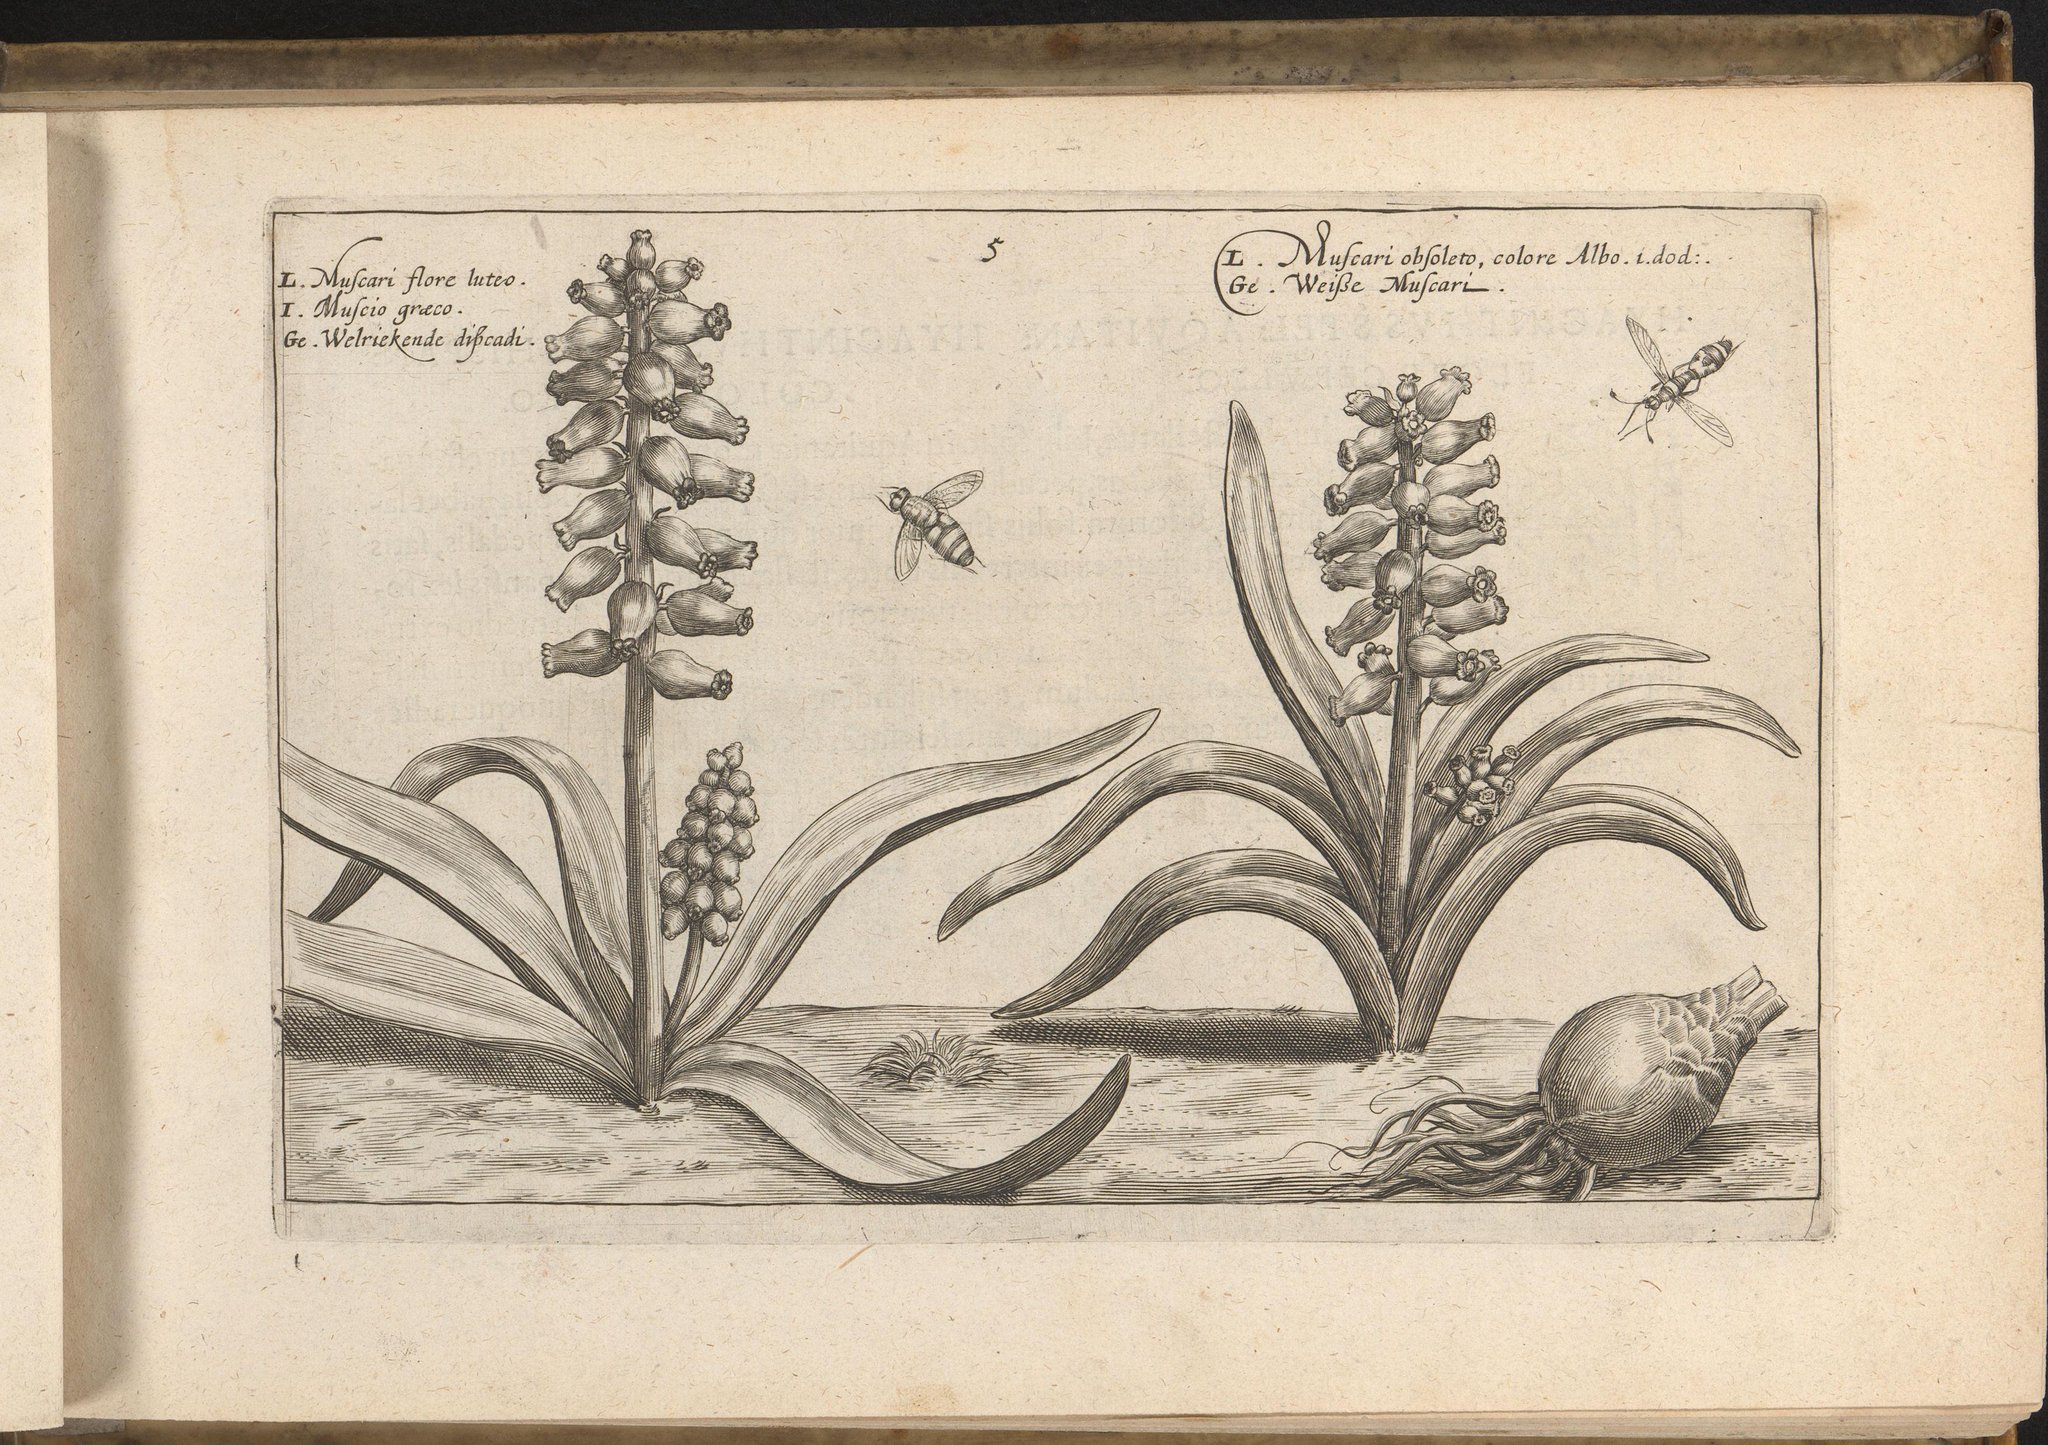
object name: print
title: Bloementuin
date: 1617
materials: paper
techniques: engraving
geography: arnhem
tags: flowers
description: Prent uit: Passe, Crispijn van de (II). Hortus floridus in quo rariorum & minus vulgarium florum icones ad vivam veramque formam. Arnhem: Johannes Janssonius, 1617.